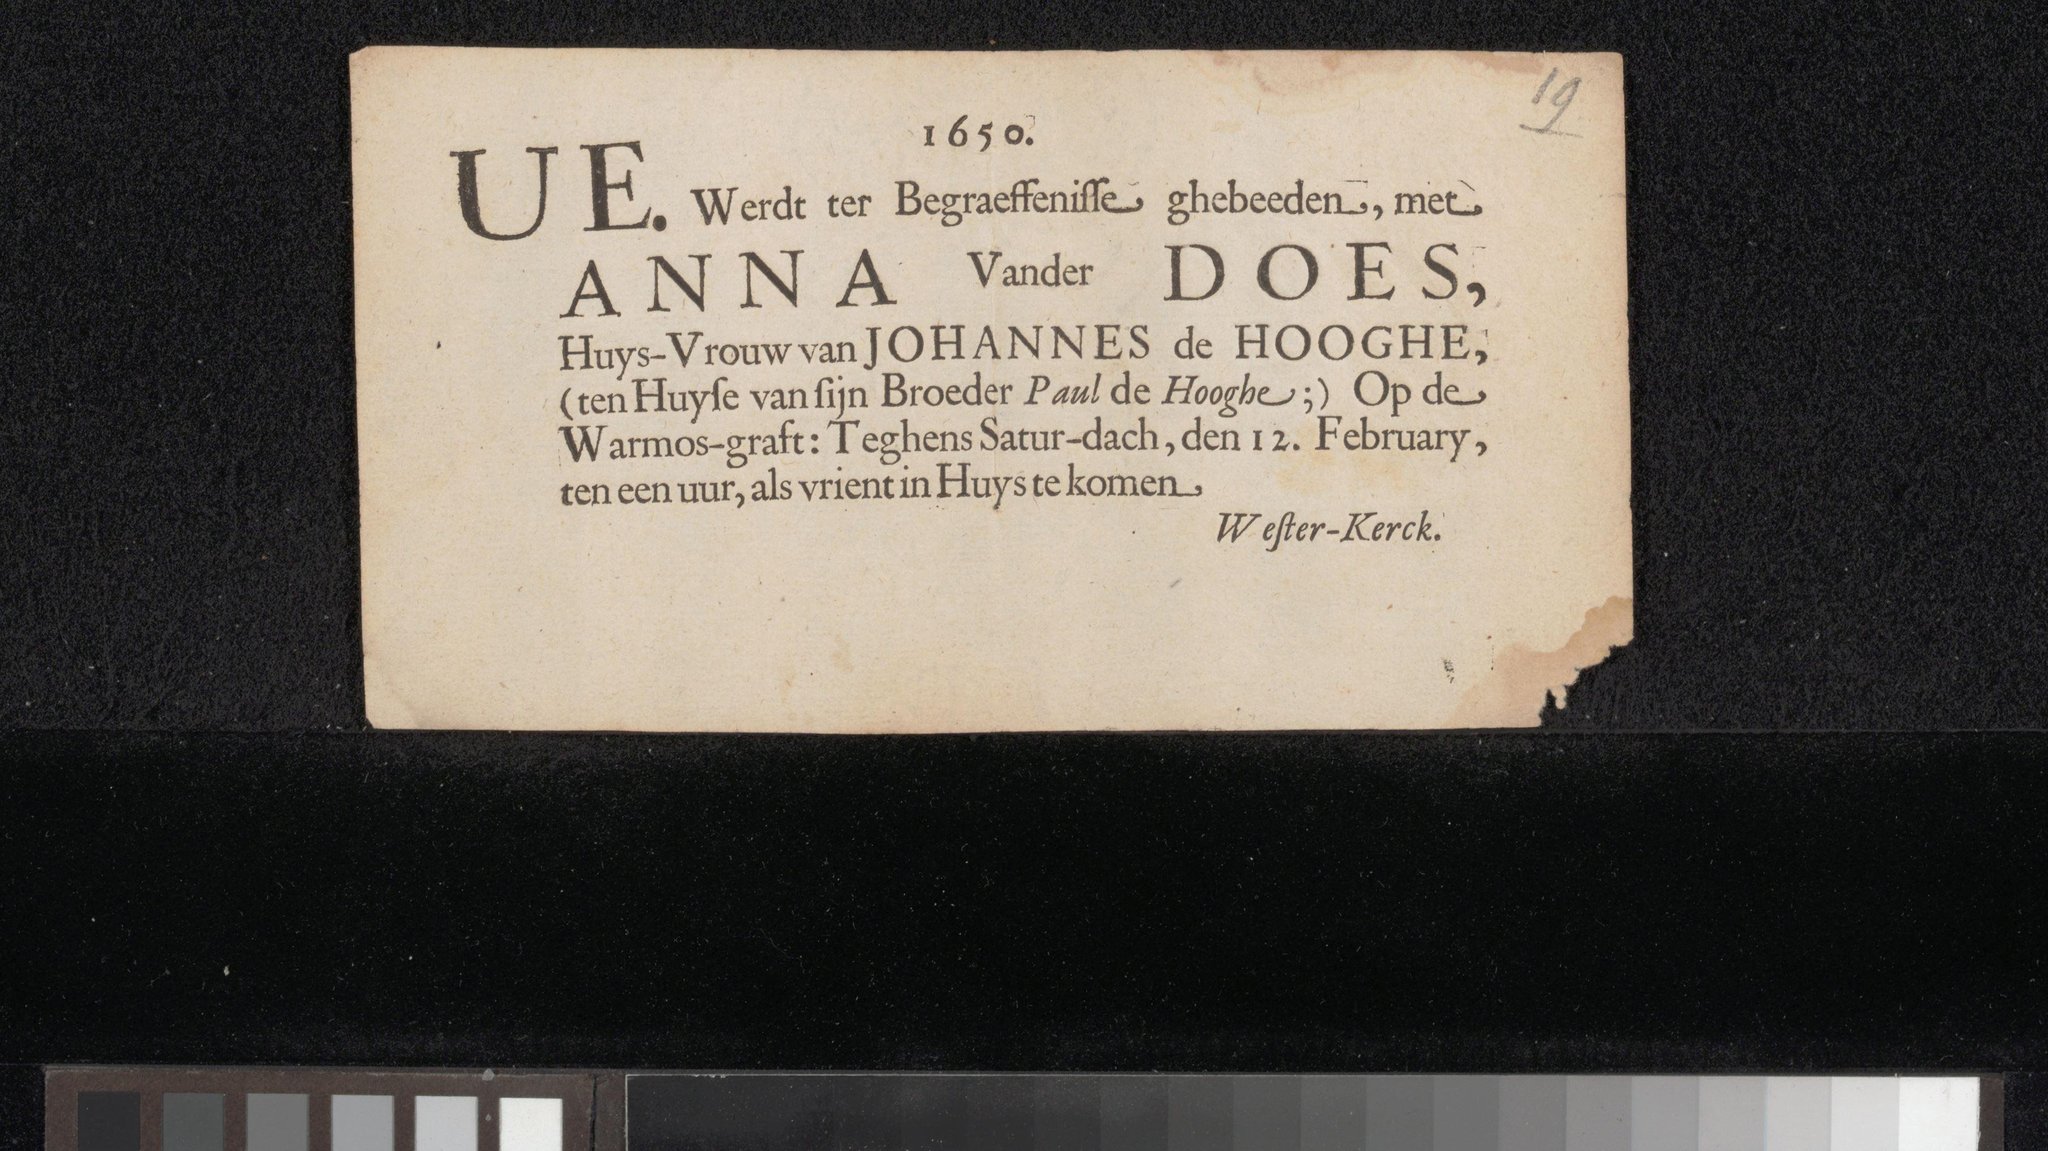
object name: invitation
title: Uitnodiging voor de begrafenis van Anna van der Does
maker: Anonymous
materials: paper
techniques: letterpress printing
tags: london, johannes de hooghe (1608-1682), paul de hooghe (1611-1674)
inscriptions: collector's mark: Lugt 2233, watermark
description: Het gerelateerd object is een portret van de overledene.